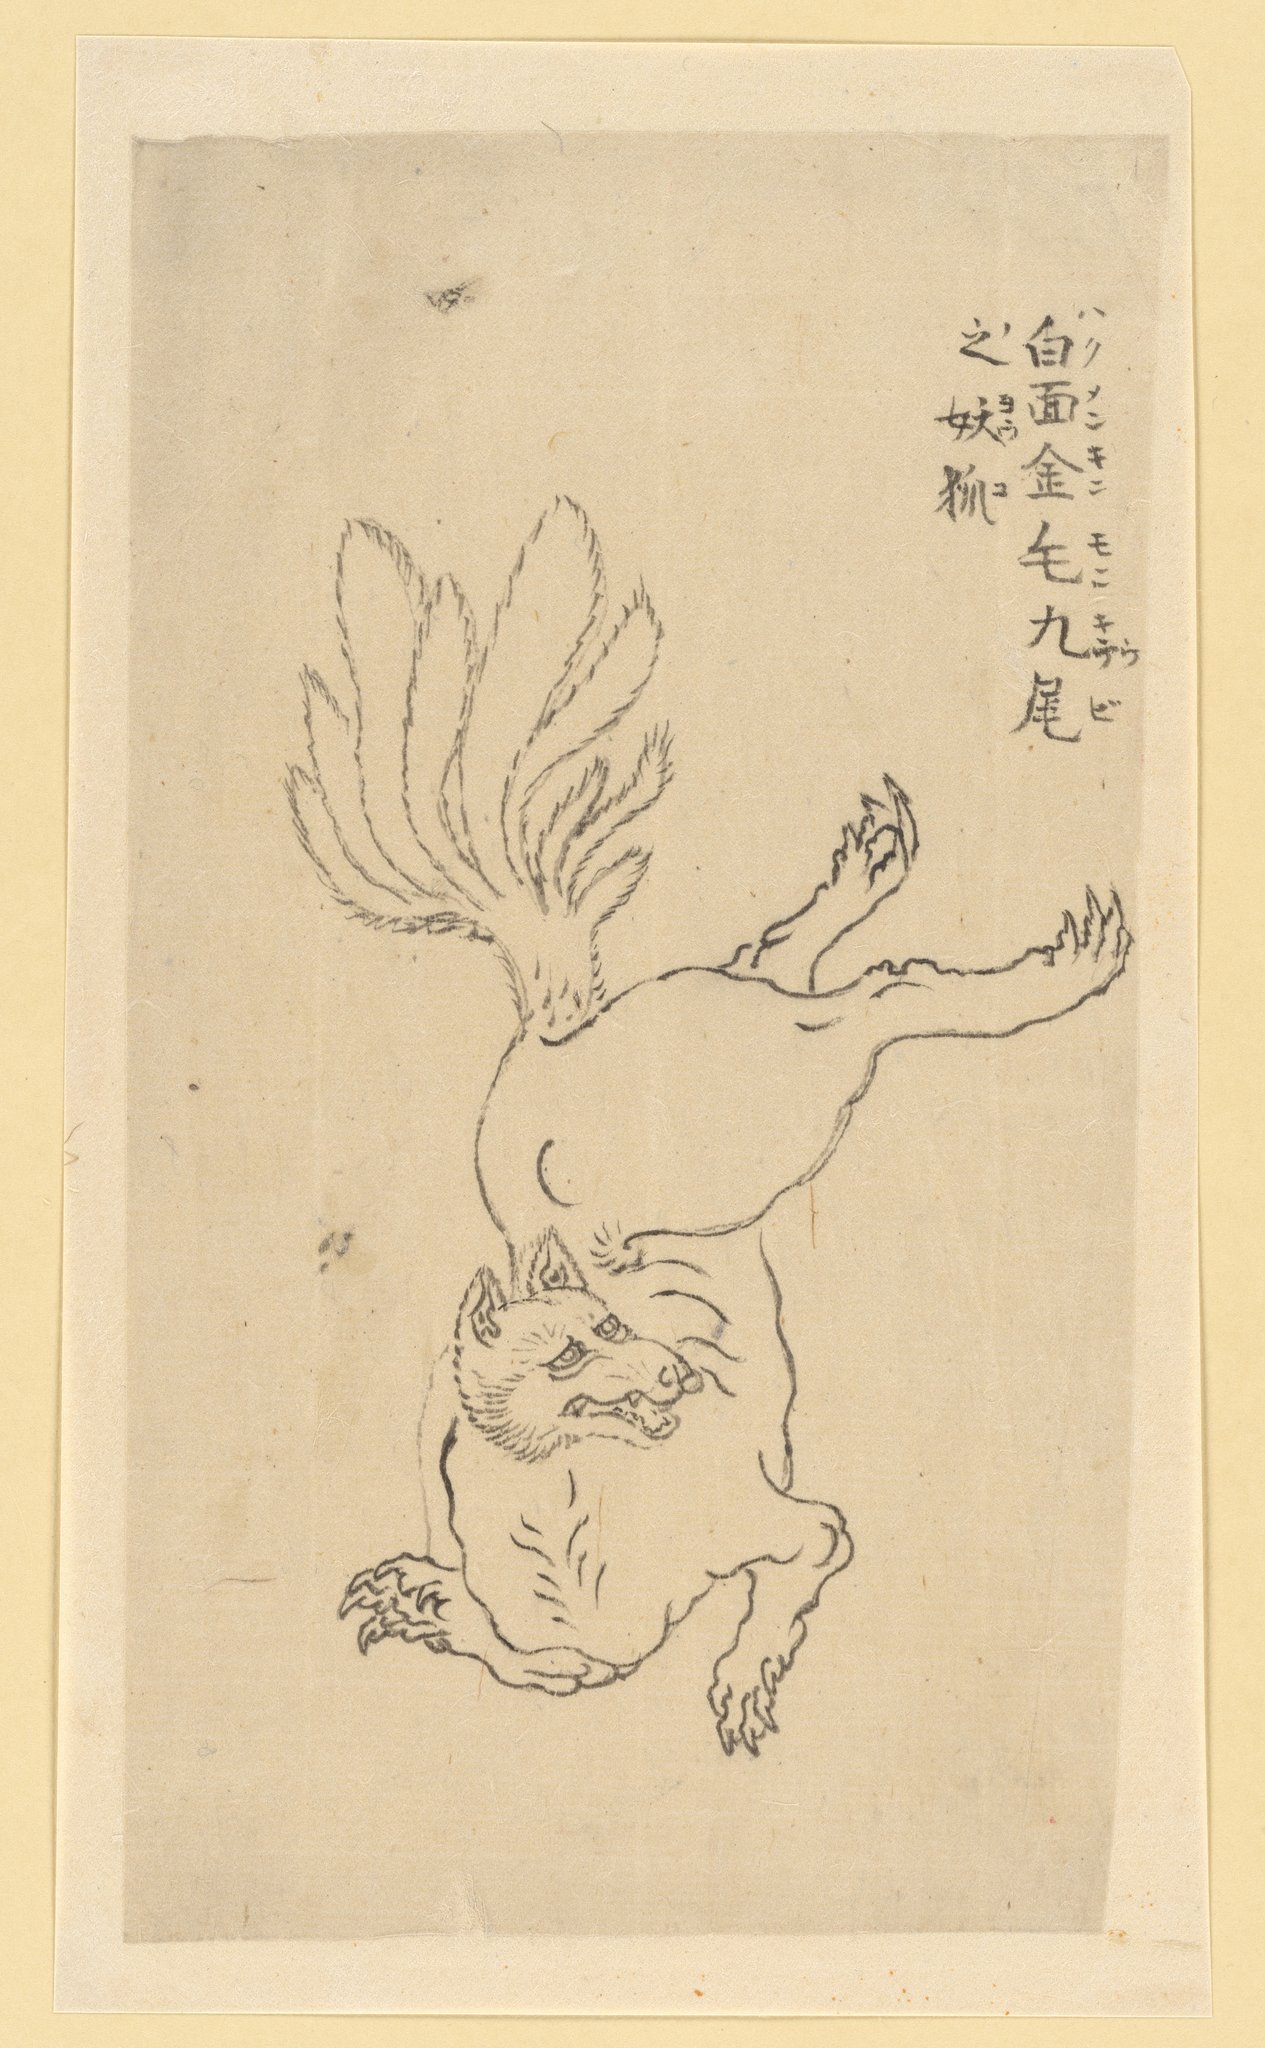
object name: drawing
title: Nine-Tailed Golden Fox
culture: japanese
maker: katsushika hokusai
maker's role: artist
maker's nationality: japanese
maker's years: 1760-1849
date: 1701-1900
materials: ink, paper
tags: foxes